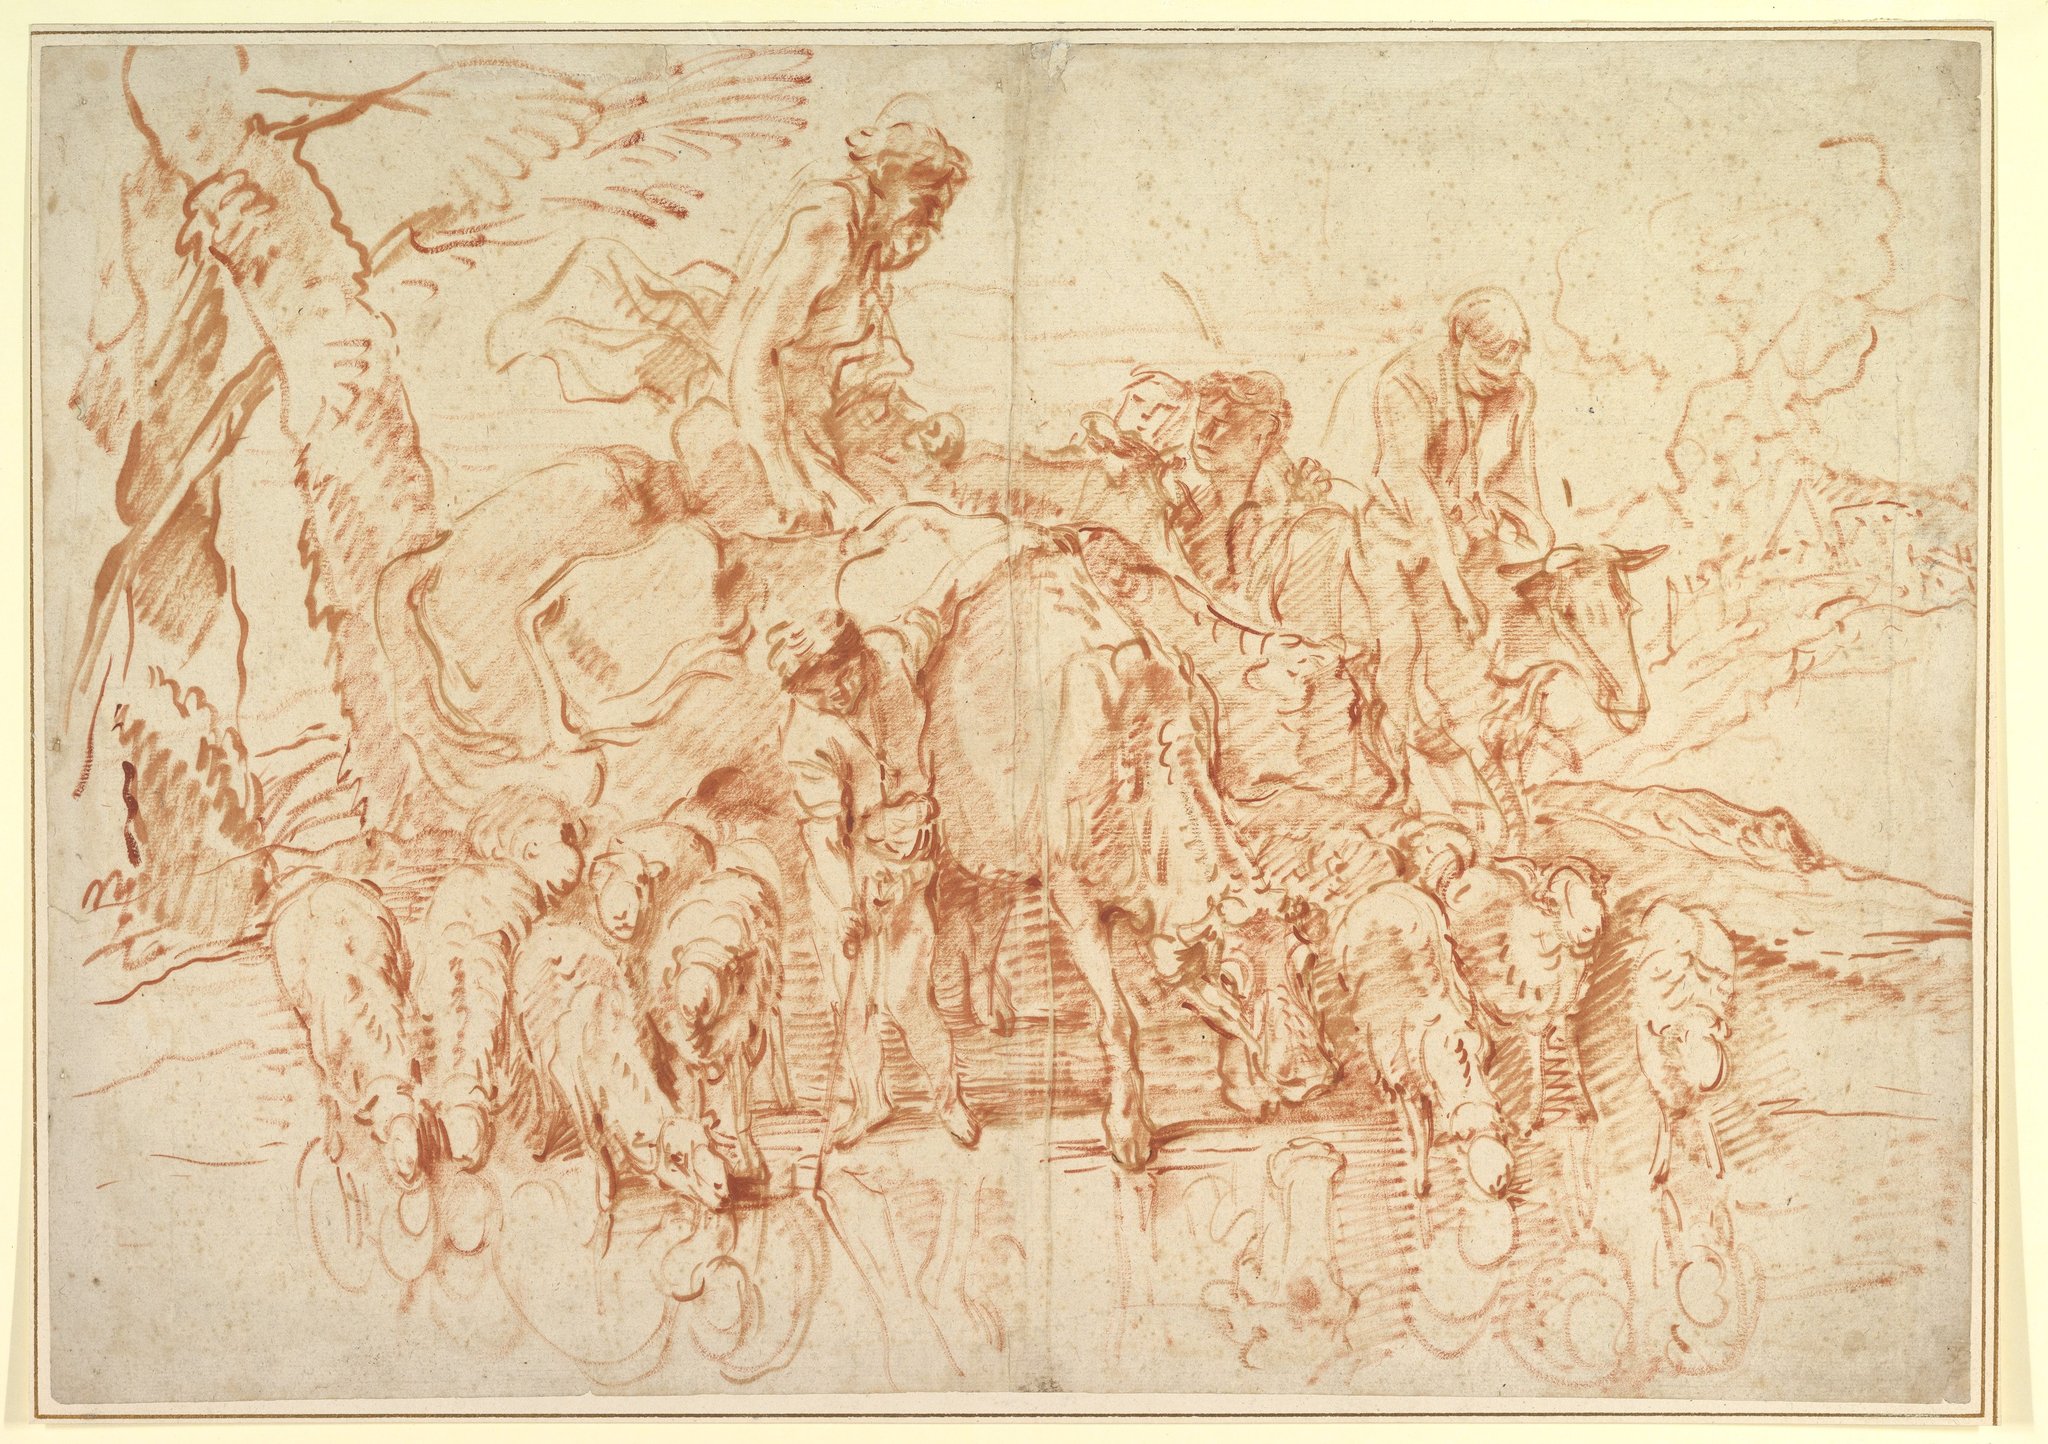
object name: drawing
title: Pastoral Journey with Flocks and Herds at a Stream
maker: giovanni benedetto castiglione (il grechetto)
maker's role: artist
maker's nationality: italian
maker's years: 1609-1664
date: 1660-1664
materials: oil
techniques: brush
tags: human figures,animals